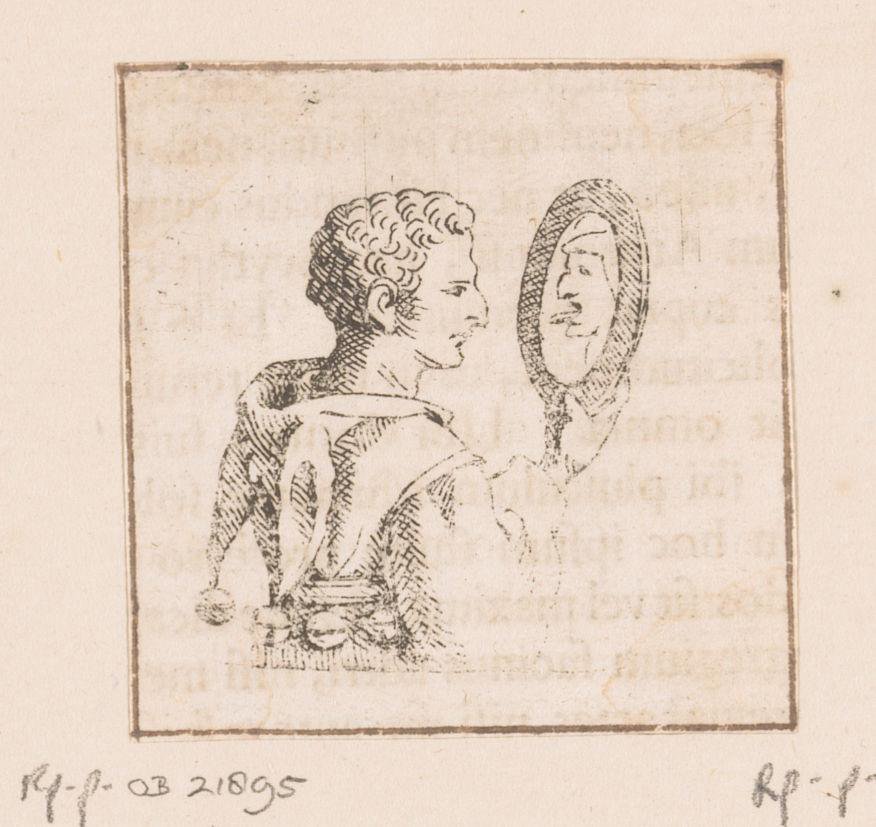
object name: book illustration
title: Illustraties uit de Lof der Zotheid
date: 1516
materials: paper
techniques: etching, letterpress printing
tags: court jester, court fool, mirror, folly, foolishness; 'pazzia', 'sciocchezza', 'stoltitia' (ripa)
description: Prent afkomstig uit: Erasmus, Desiderius. Morias enkomion (...). Bazel: Johann Rudolf Genath, 1676. De prenten hierin zijn naar tekeningen die Hans en Ambrosius Holbein maakten voor de theoloog Oswald Myconius in diens uitgave van de Moriae encomium (Lof der Zotheid) van 1516.